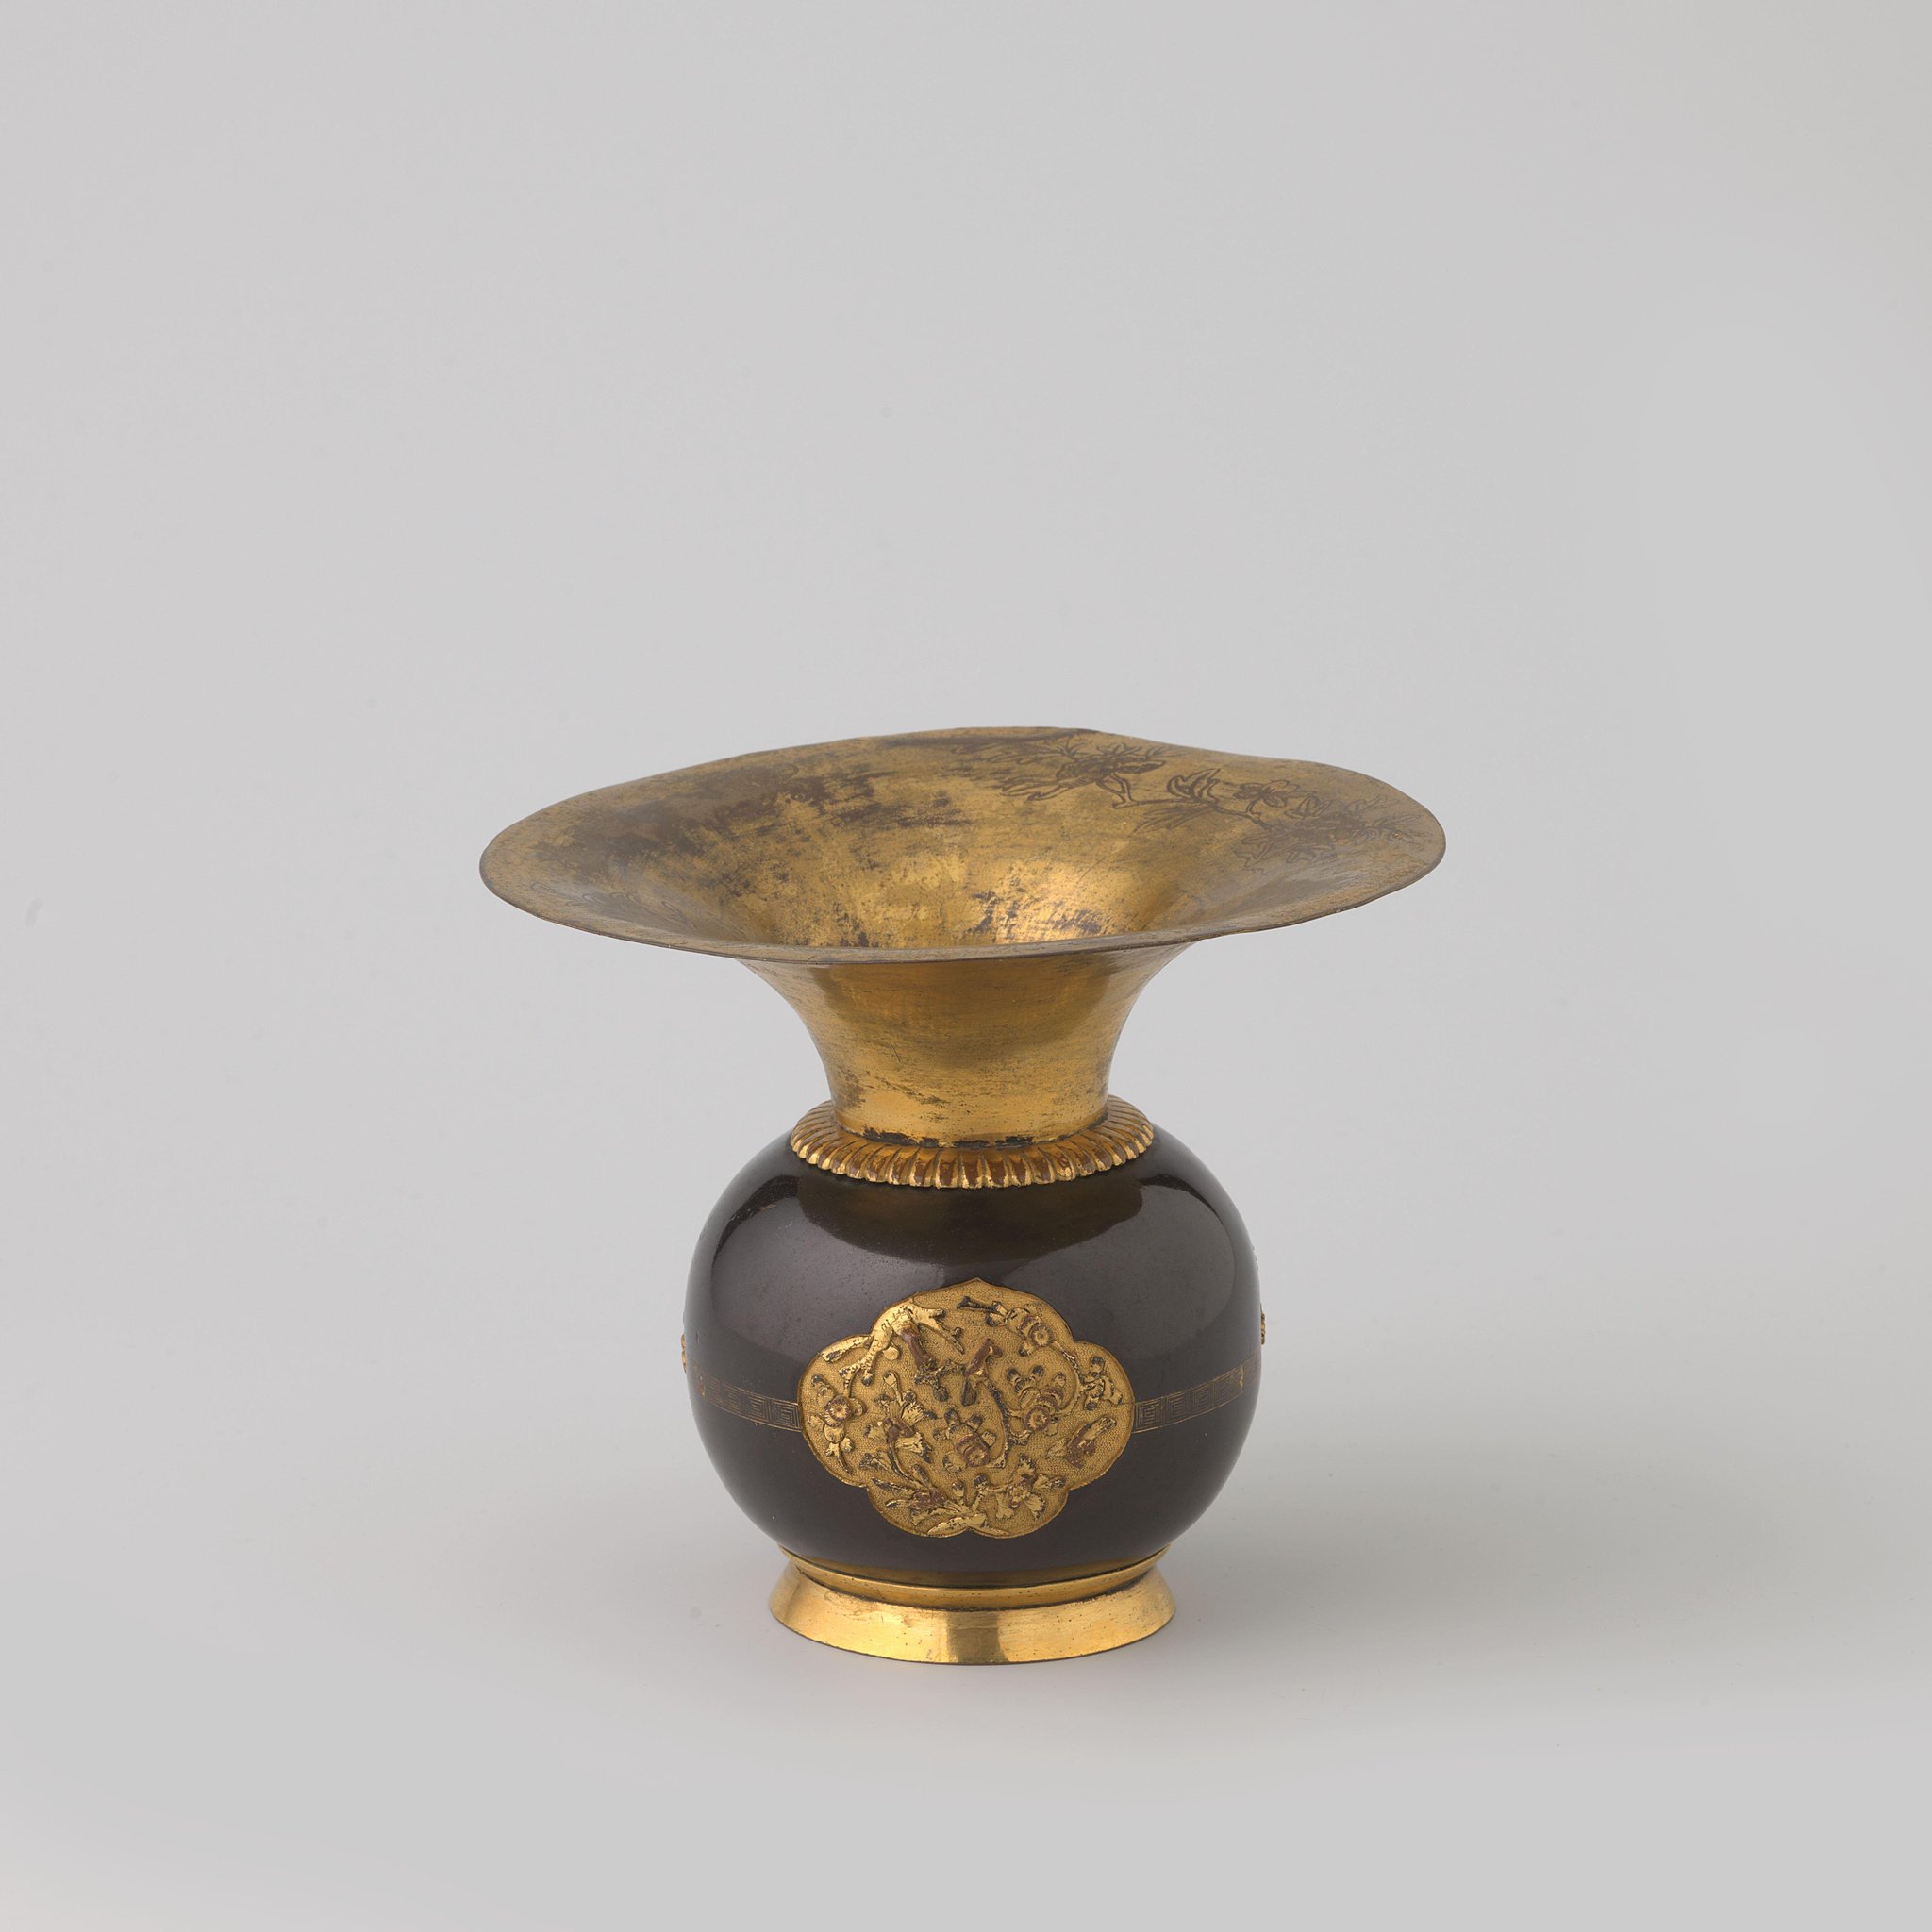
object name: spittoon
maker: Anonymous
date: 1700-1800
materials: metal alloy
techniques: amalgam gilded, casting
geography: tonkin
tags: verenigde oostindische compagnie, vietnam, kanton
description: Kwispedoor met vergulde voet en een trompetvormige mond en een zwart gelakte bolle buik versierd met drie cartouches in relief, voorstellende pagodes en een figuur in een boot temidden van een traditioneel Chinees landschap met bomen en vogels. De binnenzijde van de mond is gegraveerd met pioenen, vlinders en een vogel.